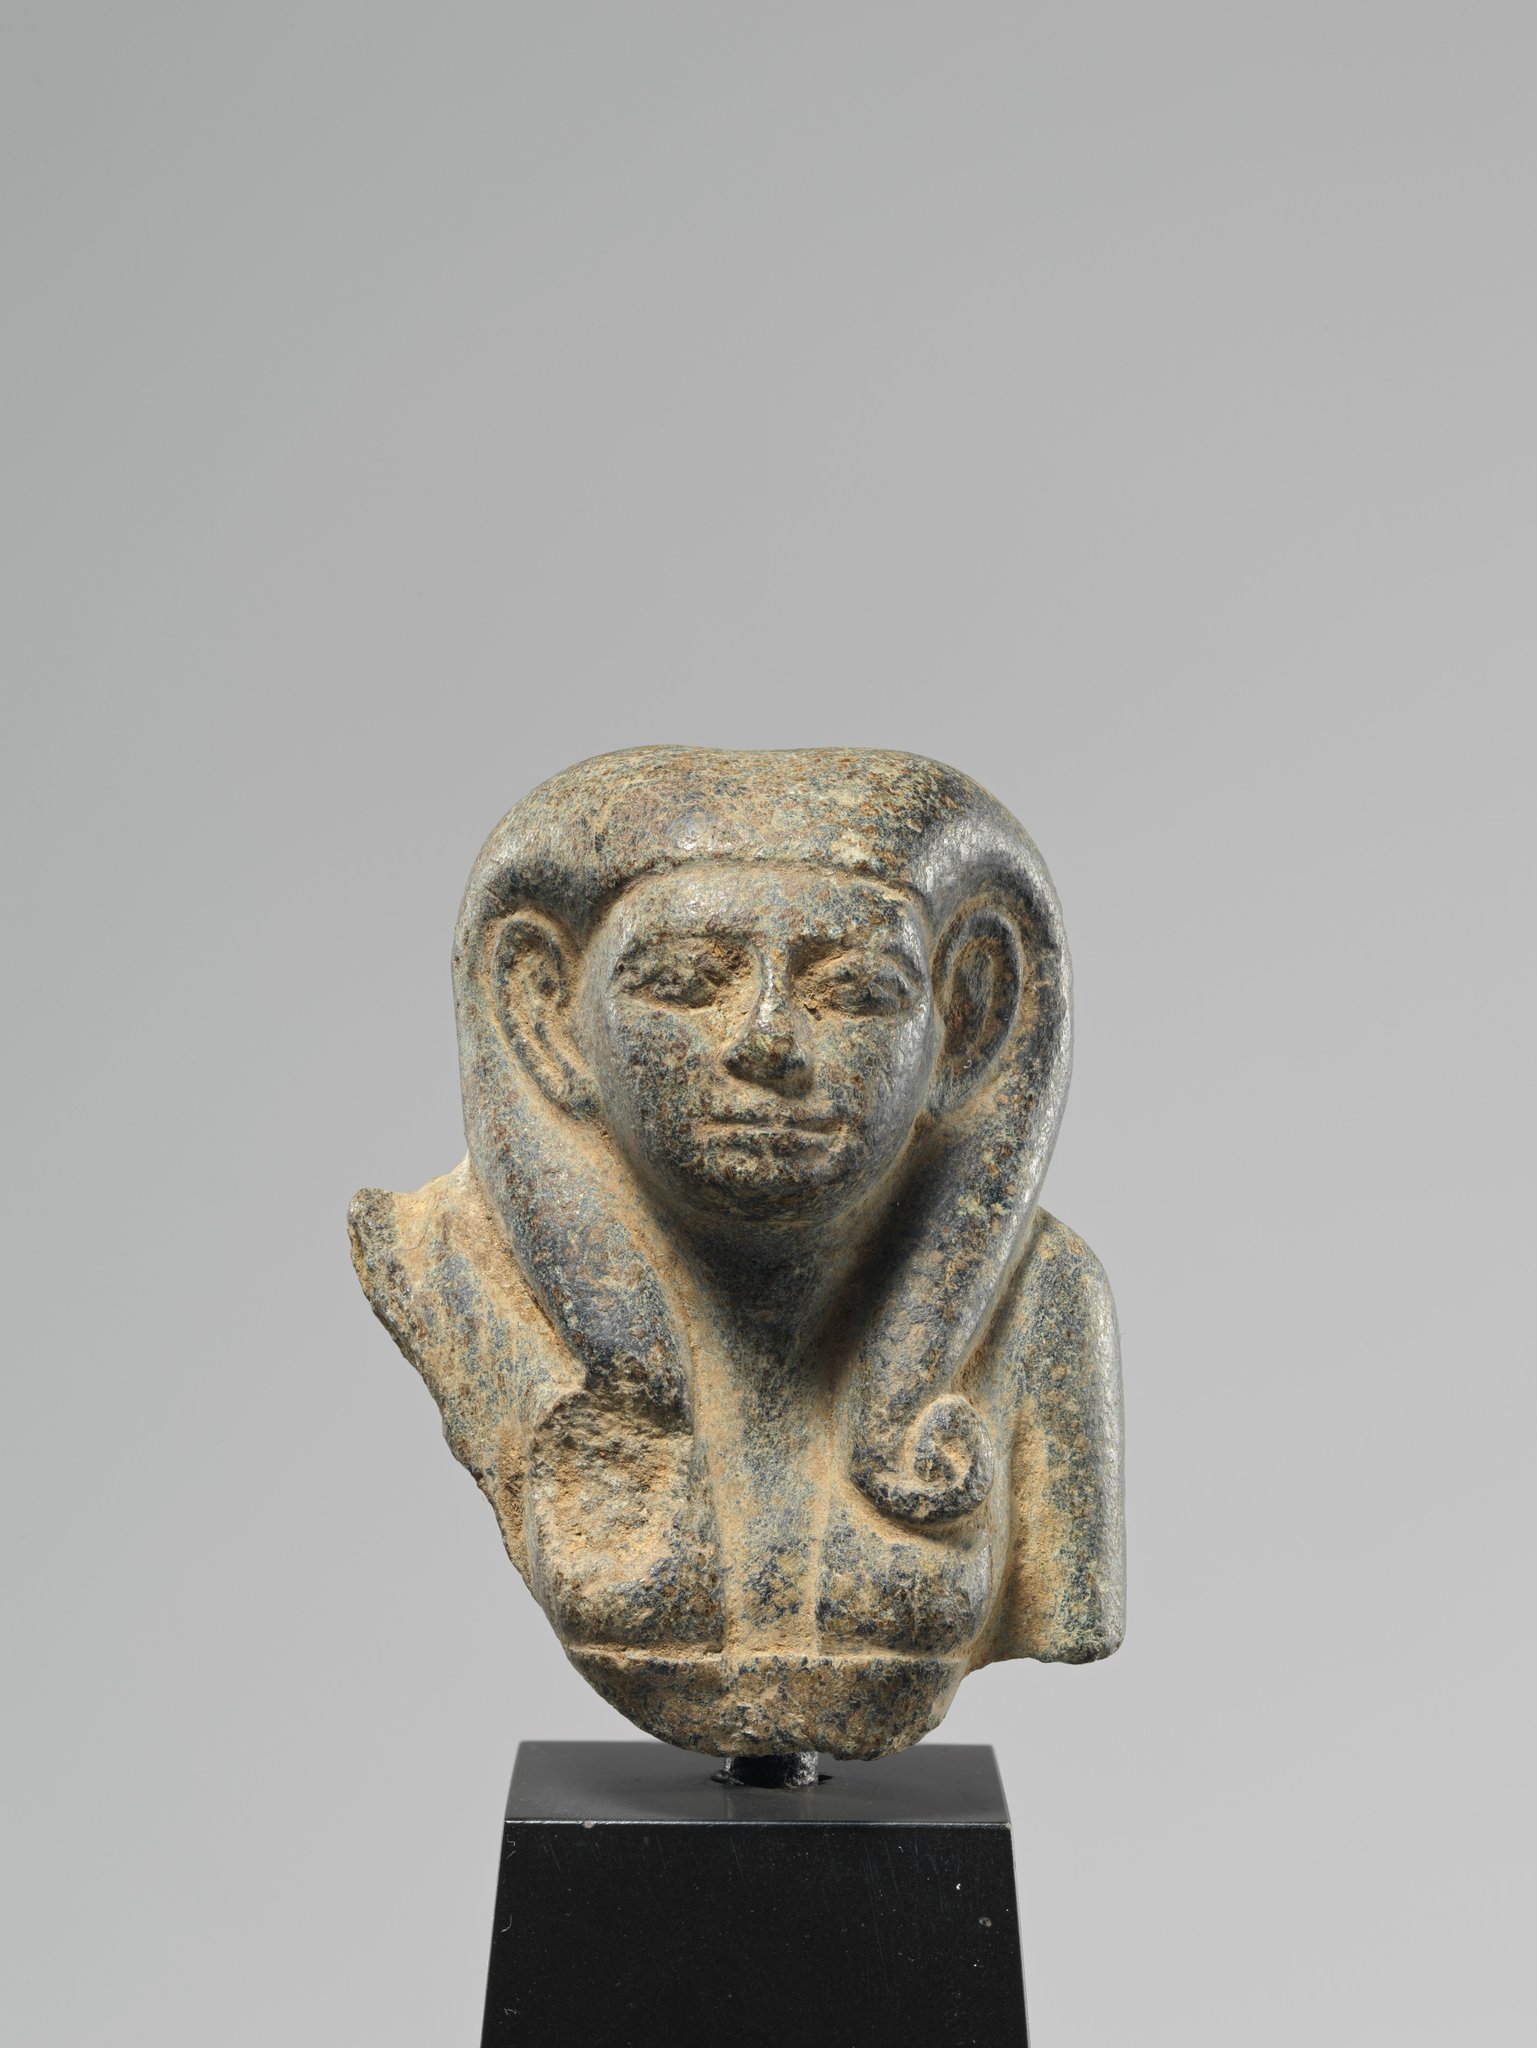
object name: upper half of a woman from a pair or group statue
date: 1850-1650 BCE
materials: stone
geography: egypt